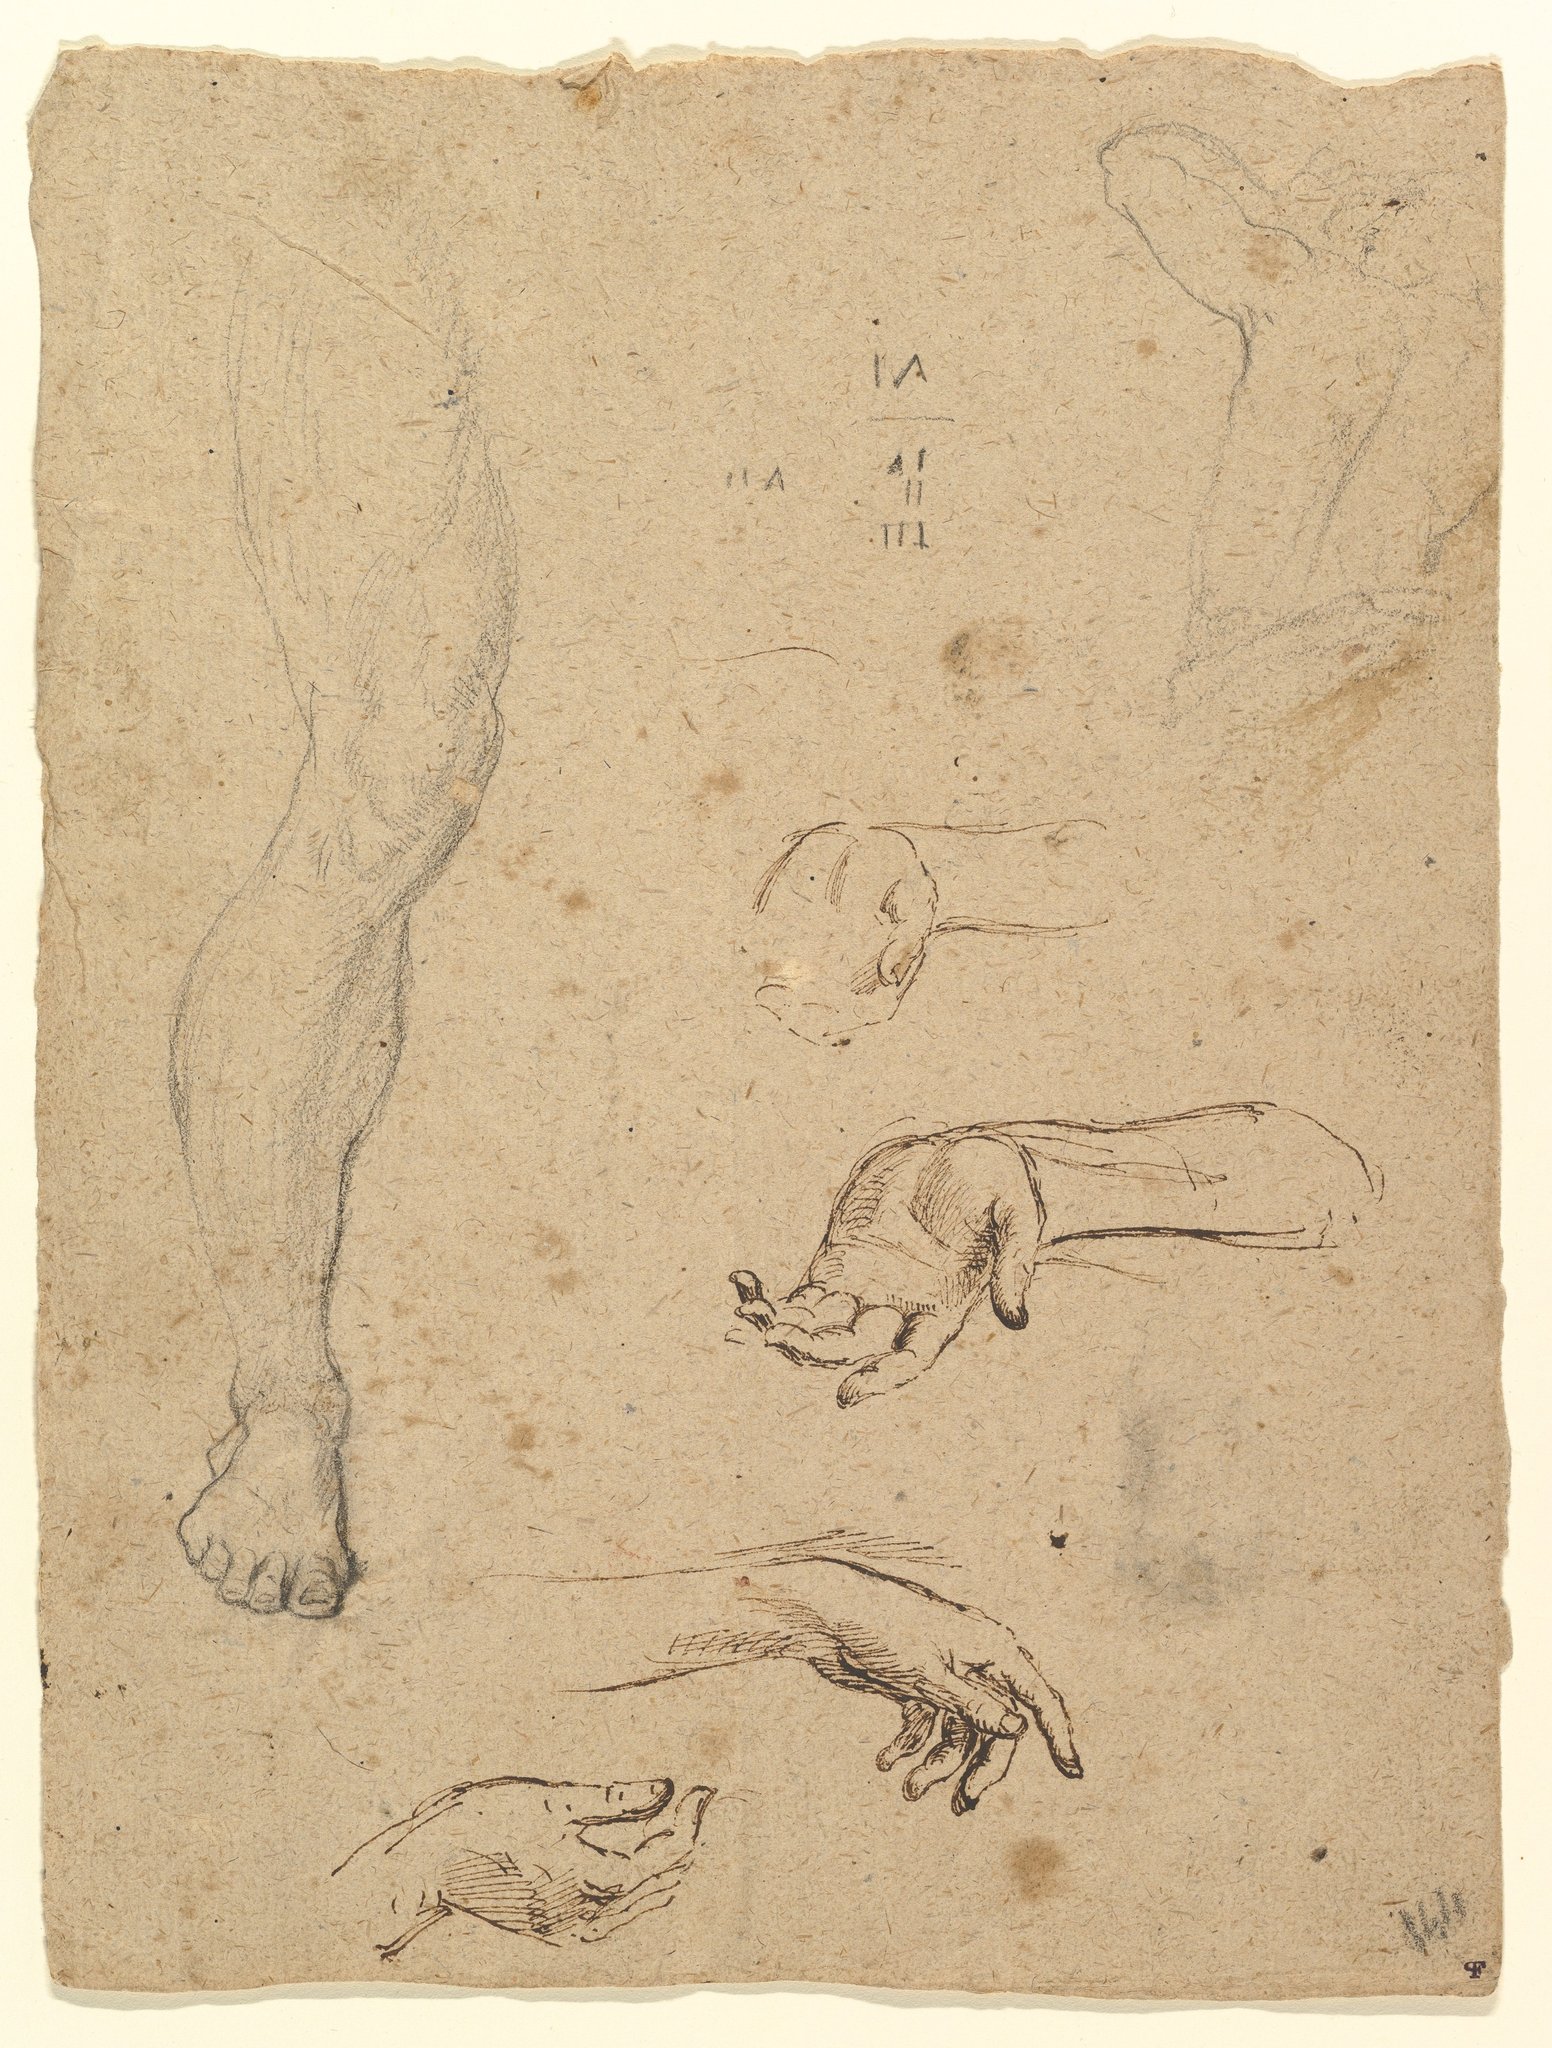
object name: drawing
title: Studies of Legs, Hands, and Torso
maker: anonymous, italian, 18th century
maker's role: artist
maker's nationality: italian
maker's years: 1700-1800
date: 1700-1750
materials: chalk, ink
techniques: pen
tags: feet,hands